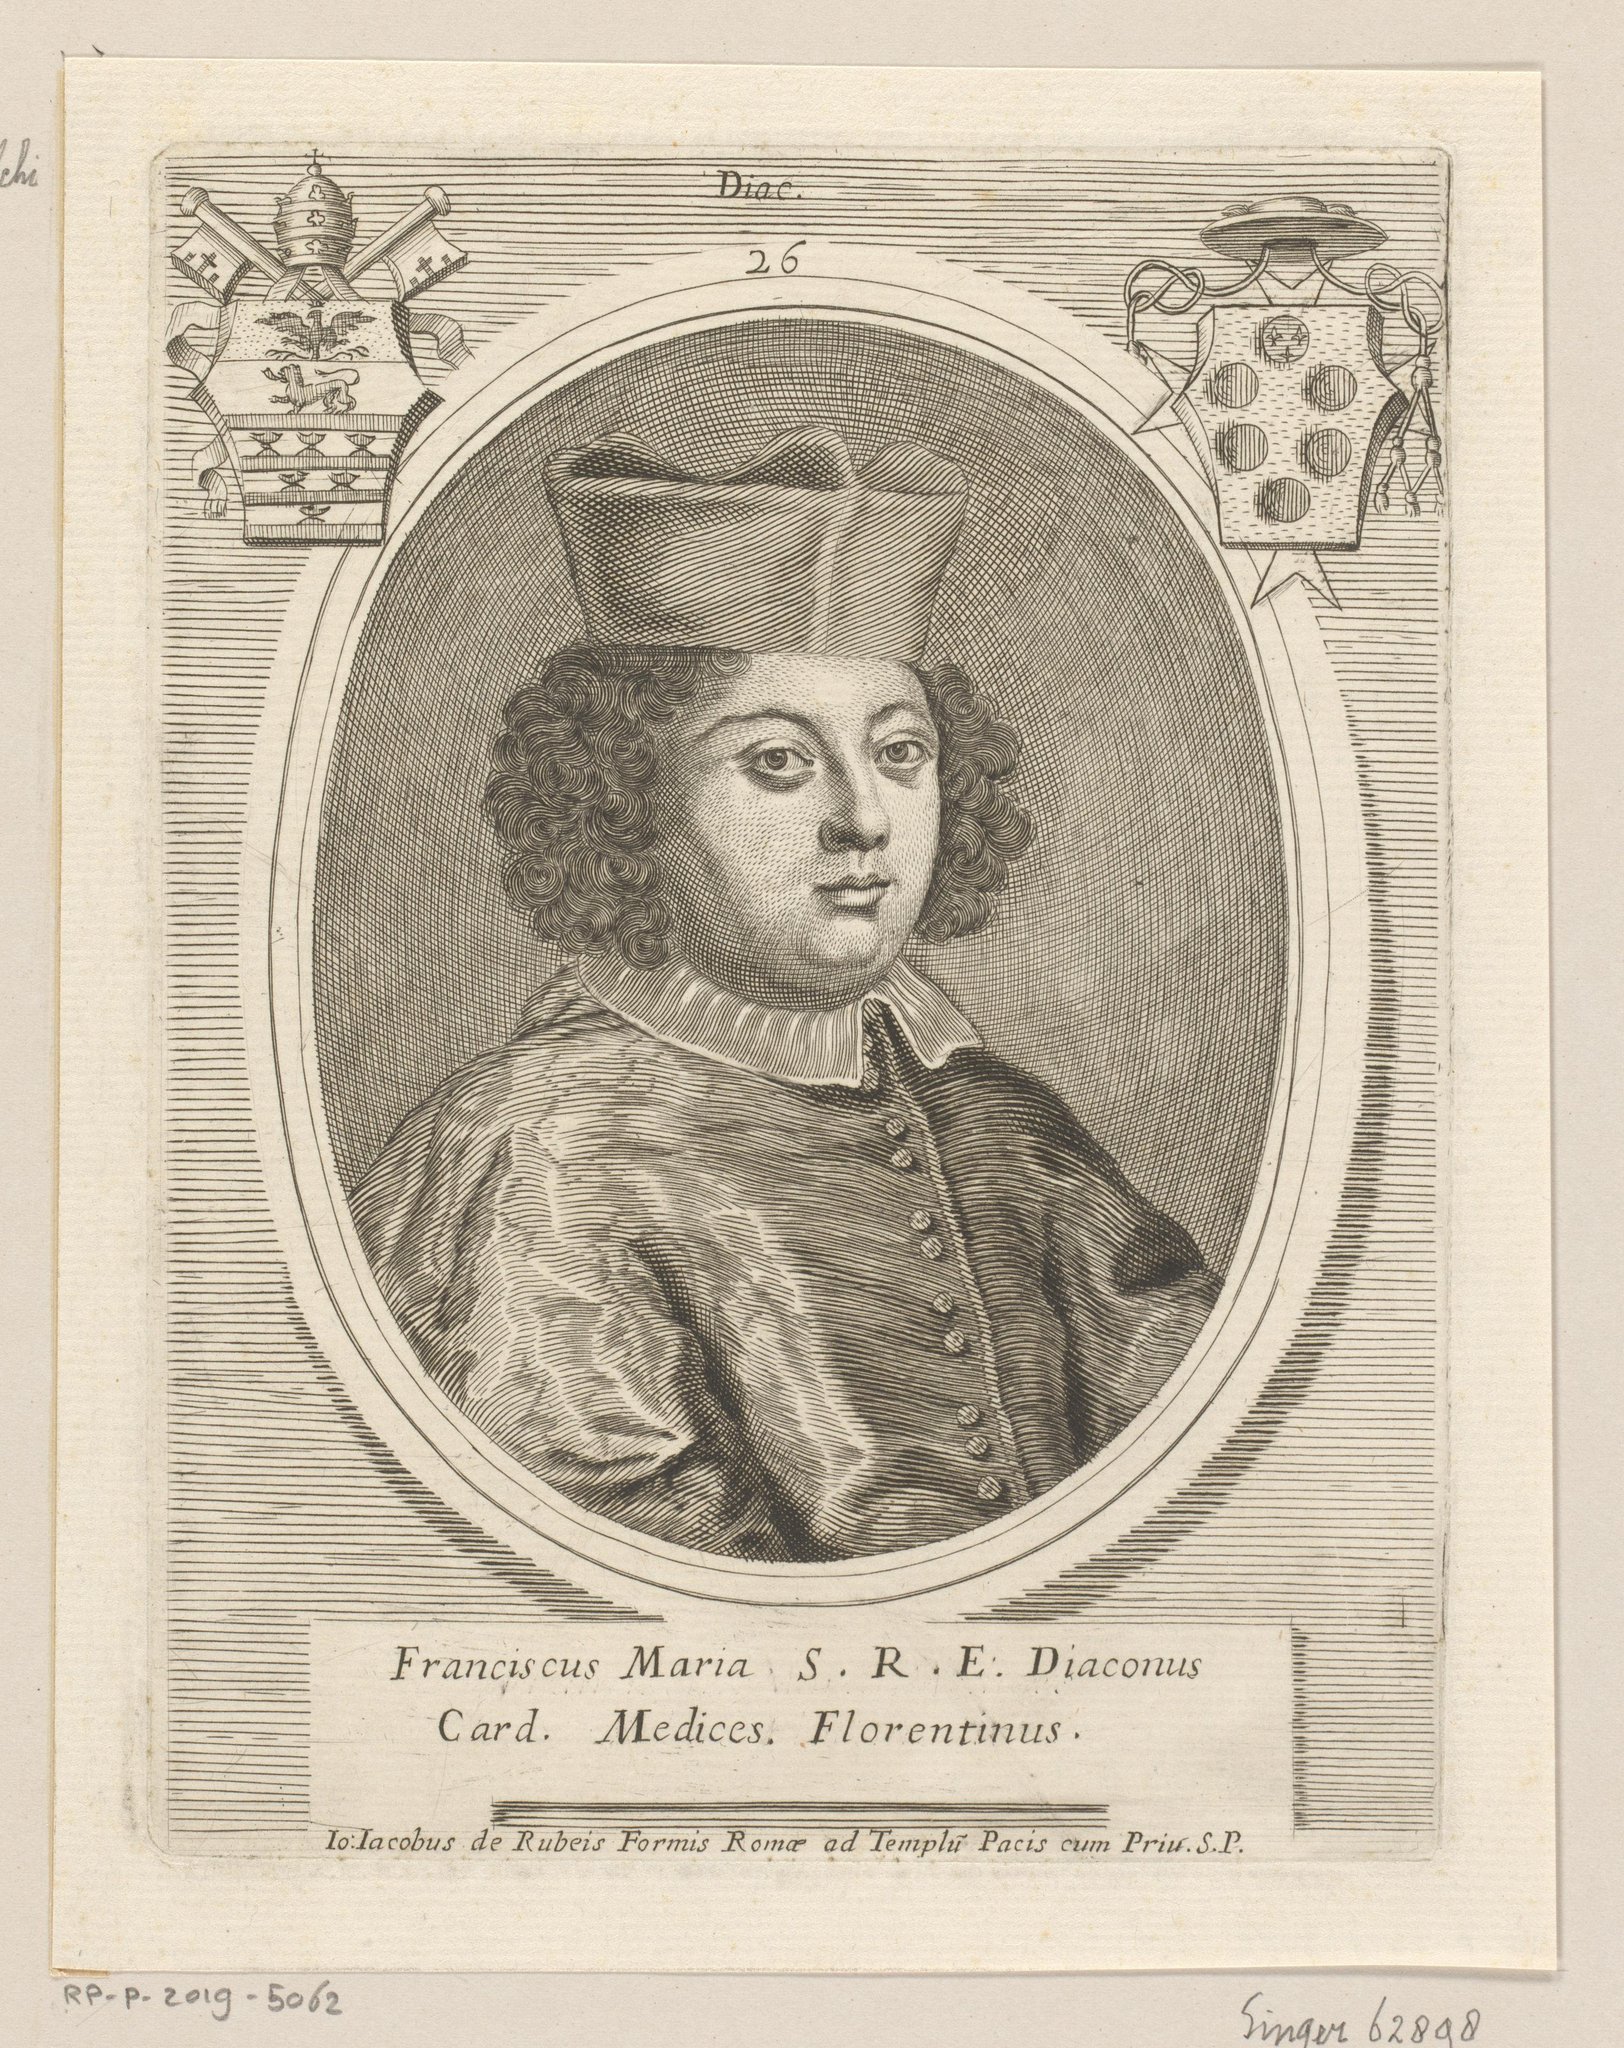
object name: print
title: Portret van kardinaal Francesco Maria de' Medici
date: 1686-1691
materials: paper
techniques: engraving, etching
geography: rome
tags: cardinal, historical persons, armorial bearing, heraldry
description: Met rechtsboven zijn wapenschild en linksboven het wapen van paus Innocentius XI.